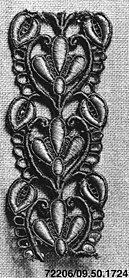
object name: passementerie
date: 1801-1900